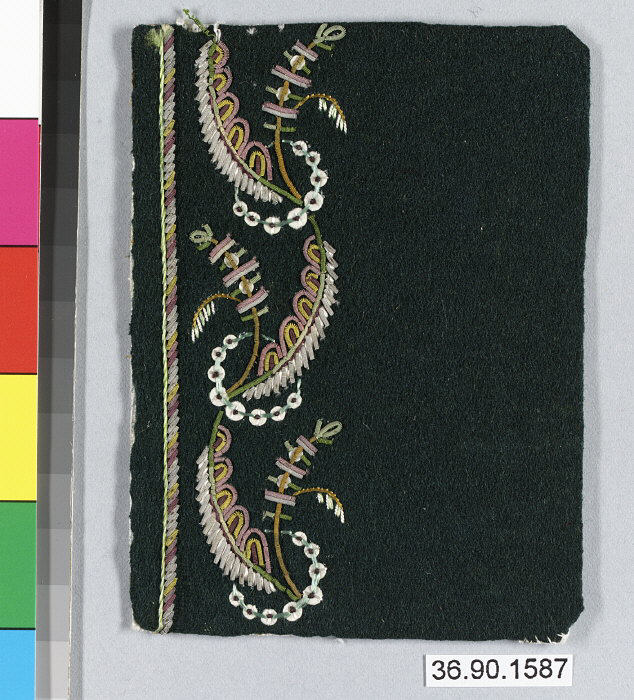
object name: sample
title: Embroidery sample for a man’s suit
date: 1785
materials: metal thread, silk, wool